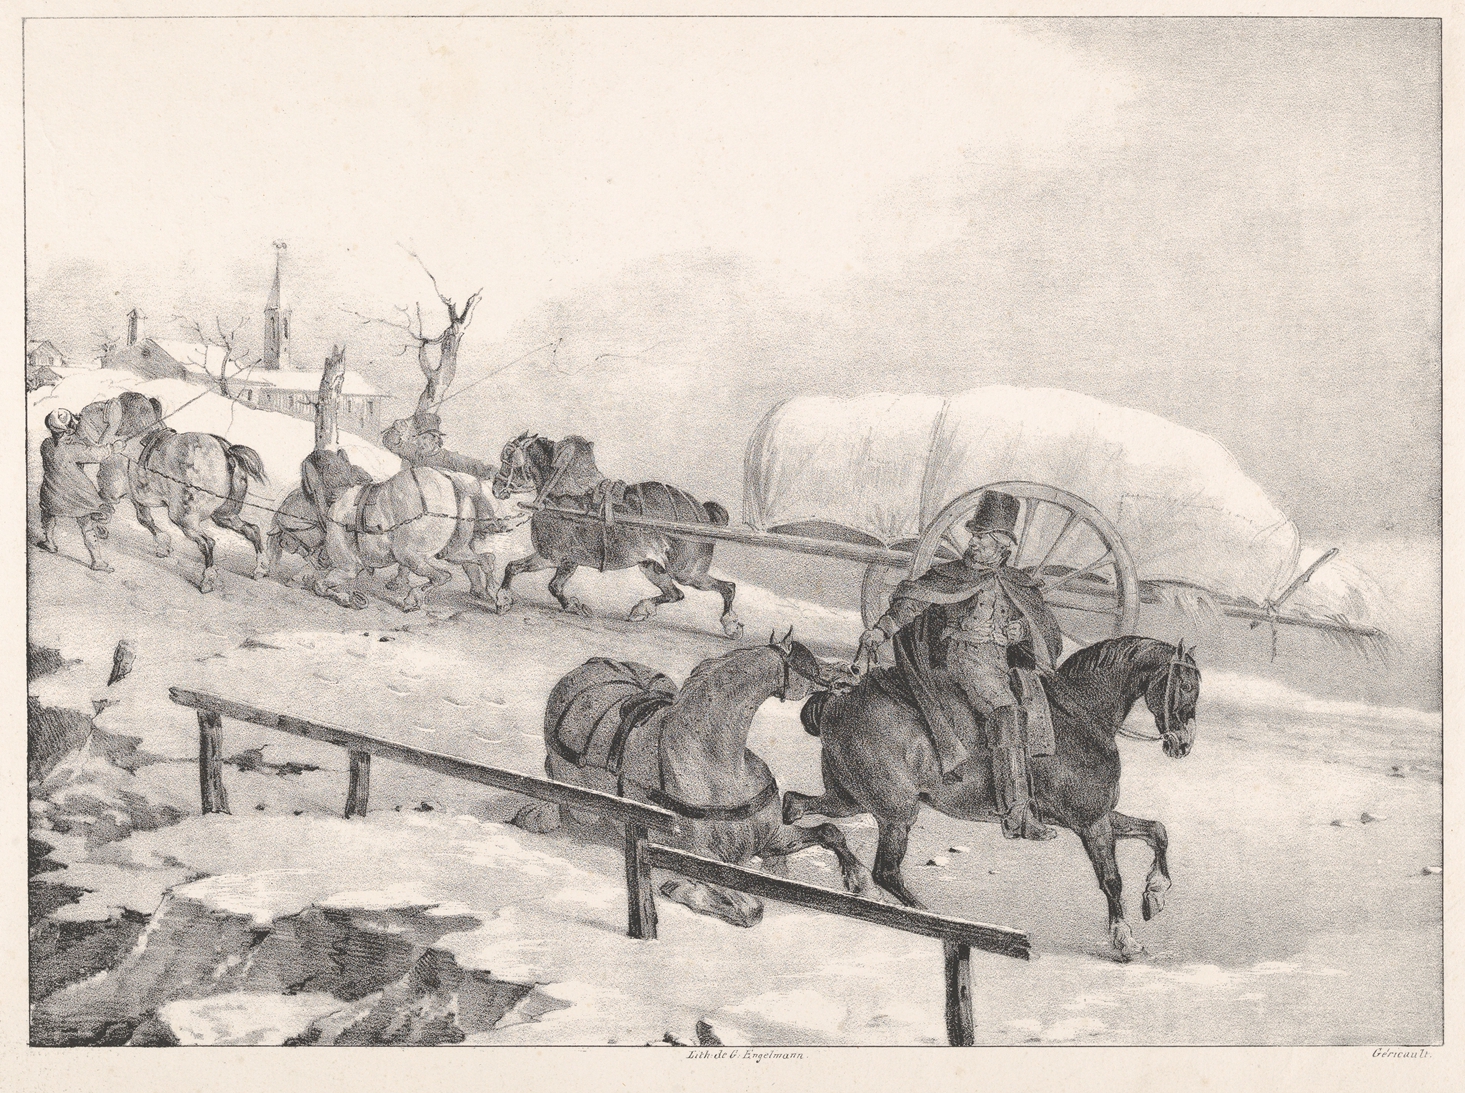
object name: print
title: Wagoner Climbing a Hill, from "Four Diverse Subjects" (Quatre sujets divers)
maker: jean louis andré théodore géricault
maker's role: artist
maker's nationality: french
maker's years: 1791-1824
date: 1823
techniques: lithograph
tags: men,horses,snow